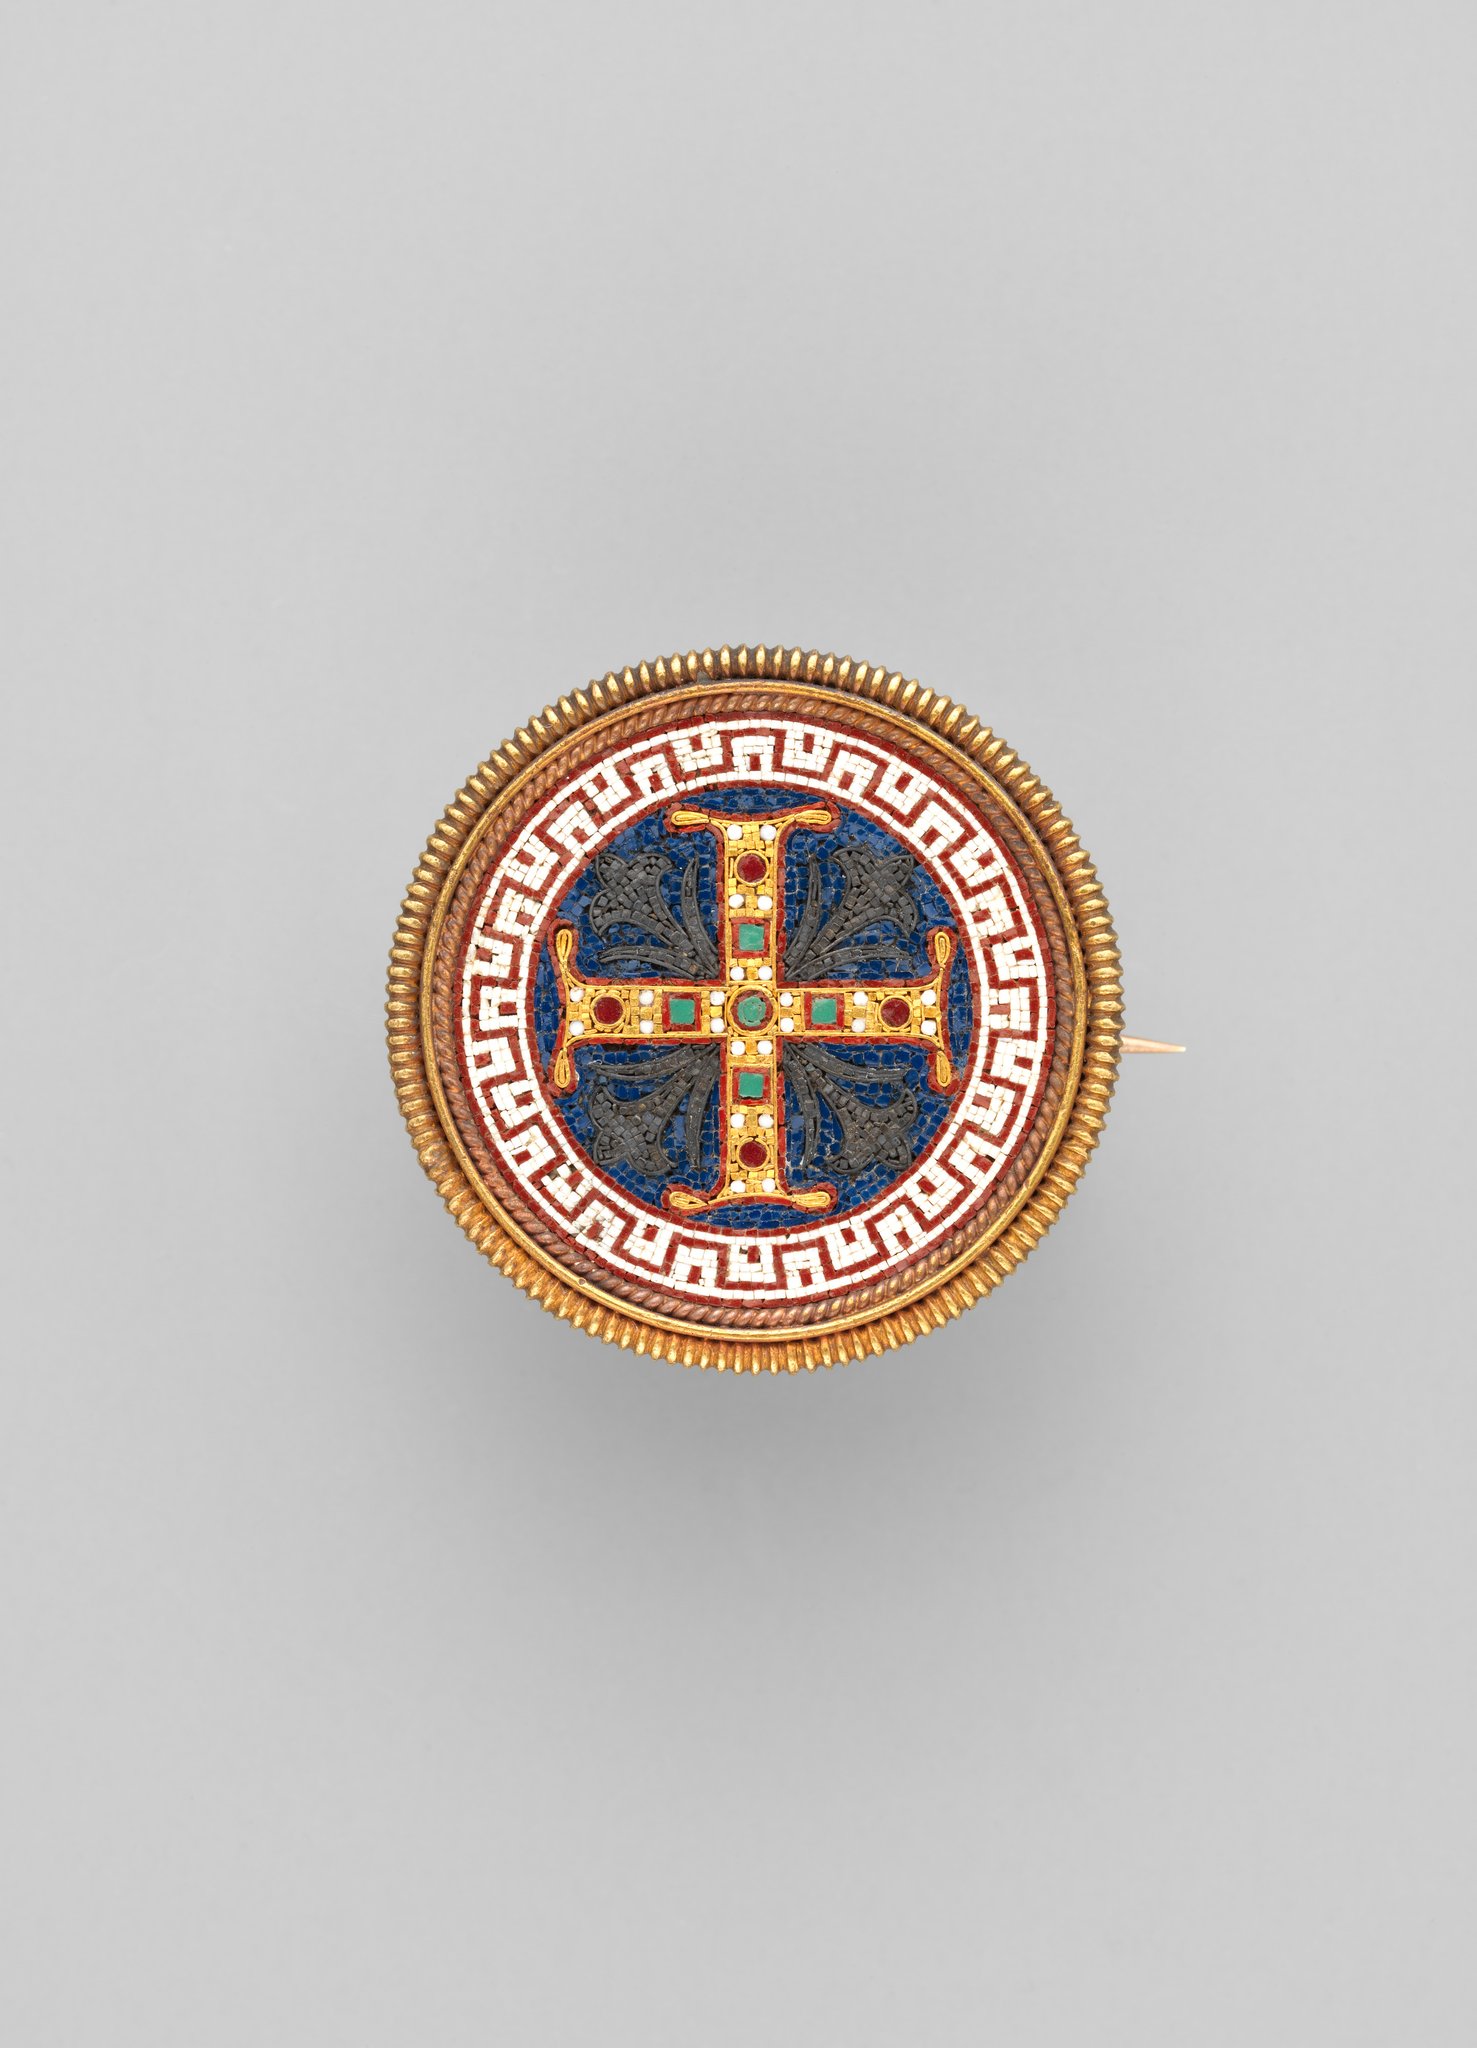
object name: brooch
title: Brooch with Greek Cross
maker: castellani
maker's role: maker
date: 1860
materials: glass, gold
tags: cross